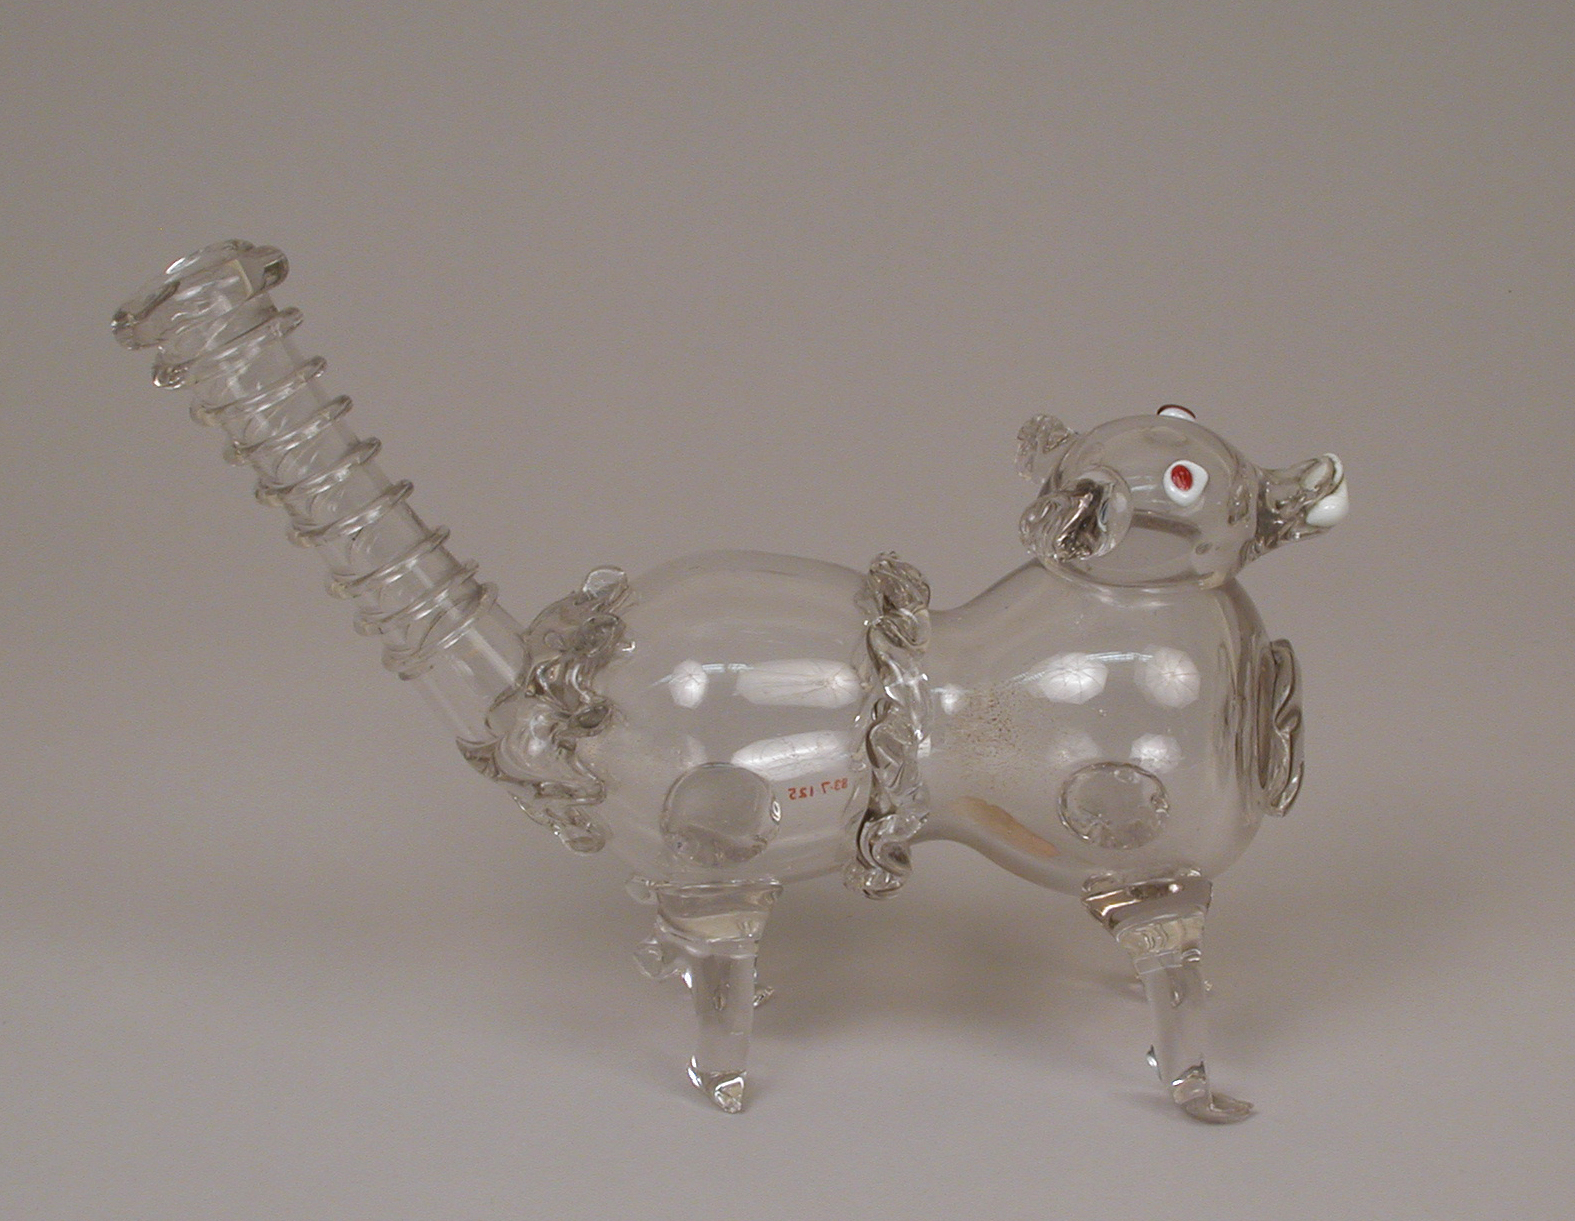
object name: bottle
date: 1701-1800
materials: glass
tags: animals